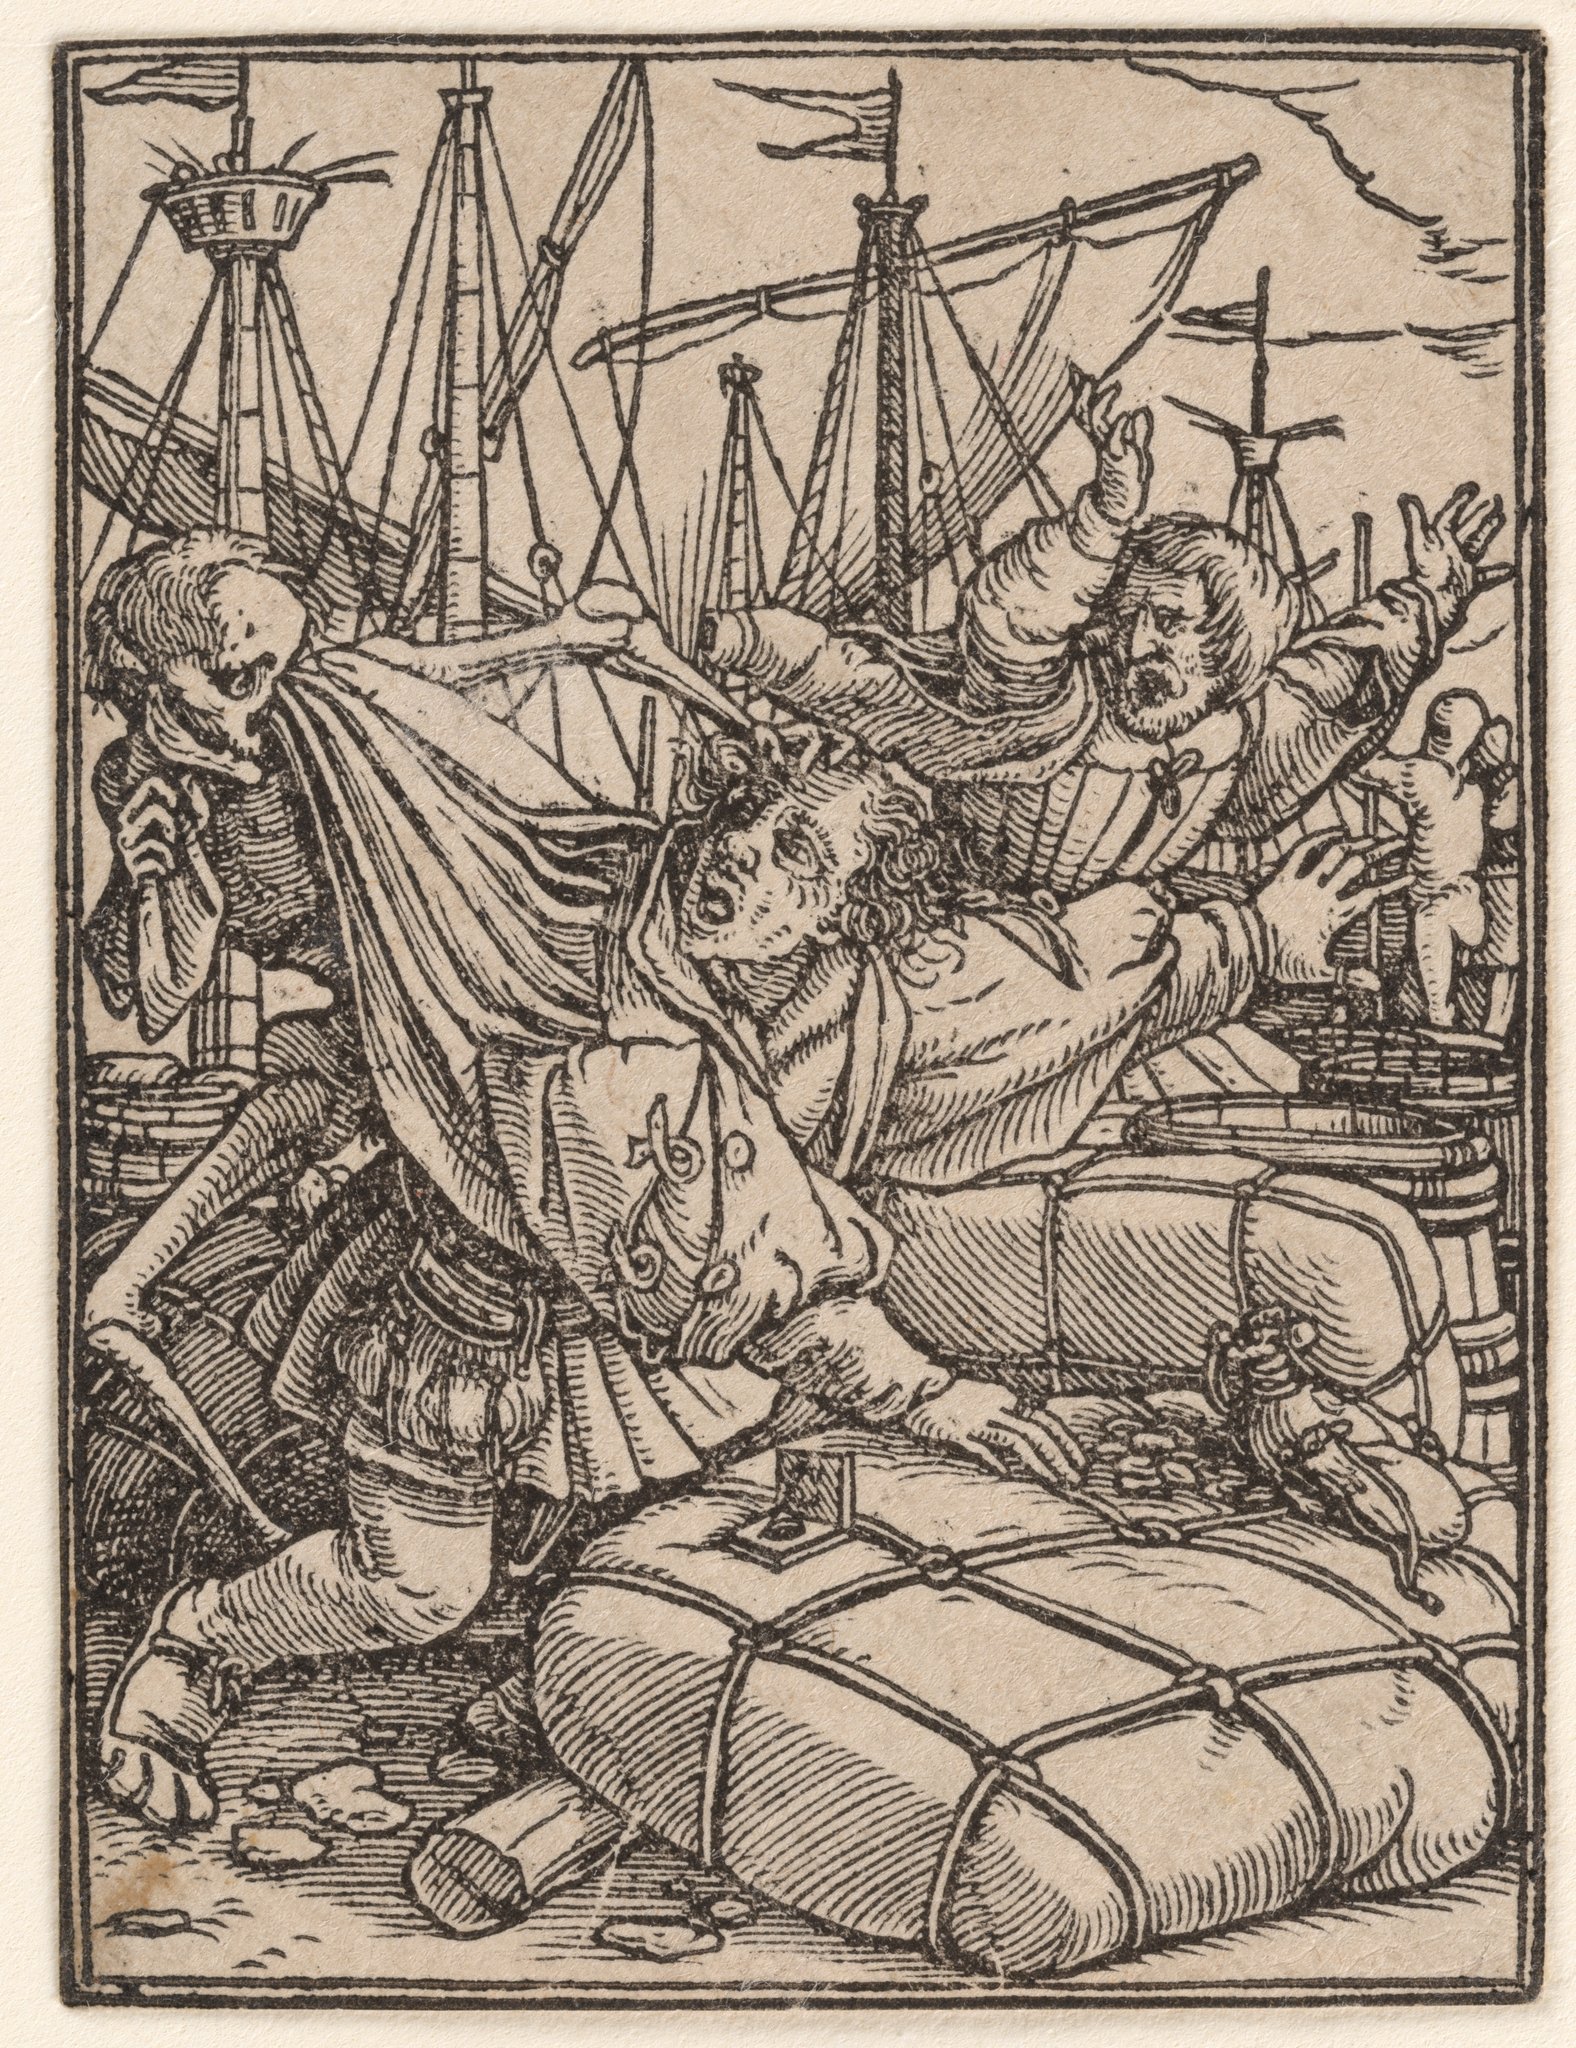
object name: print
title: The Merchant, from "The Dance of Death"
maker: hans holbein the younger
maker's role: artist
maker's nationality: german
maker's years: 1497-1543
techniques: woodcut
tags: skeletons,men